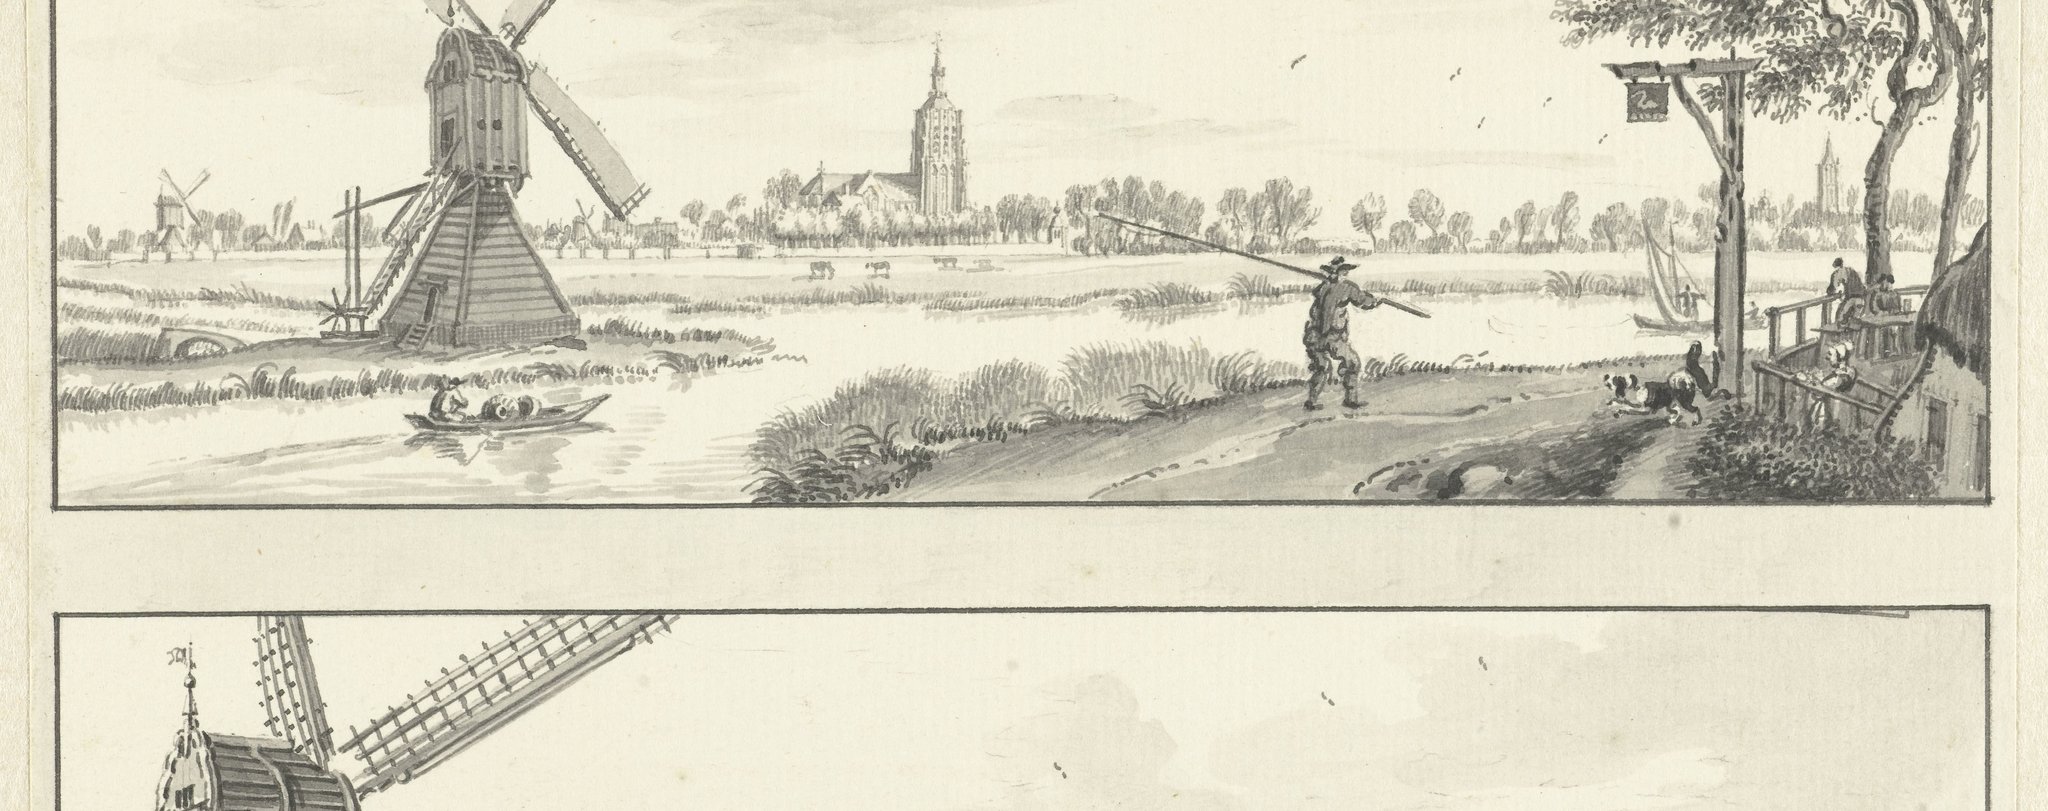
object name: drawing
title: Gezicht op Asperen en Heukelum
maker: jan de beijer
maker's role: draughtsman, print maker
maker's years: 1703-1780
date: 1750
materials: ink, paper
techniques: brush, pen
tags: prospect of city, town panorama, silhouette of city, asperen